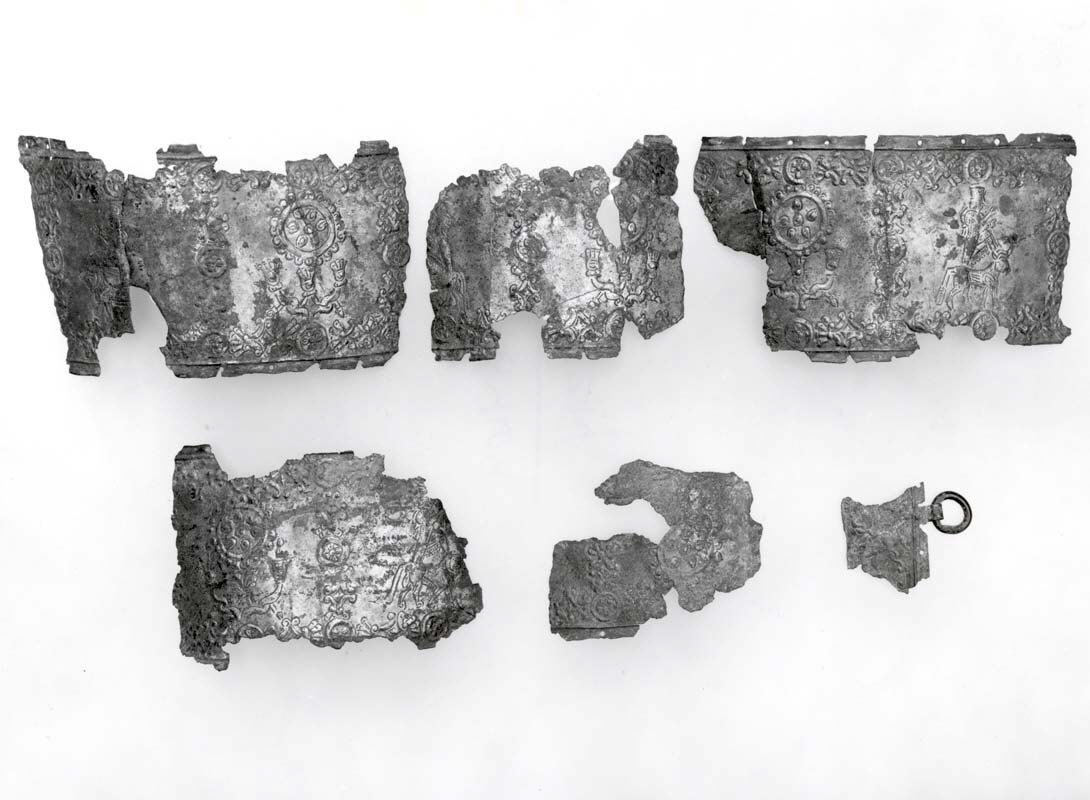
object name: belt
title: Belt fragments with deities on bulls and lions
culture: urartian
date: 700-601 BCE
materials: bronze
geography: urartu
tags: animals